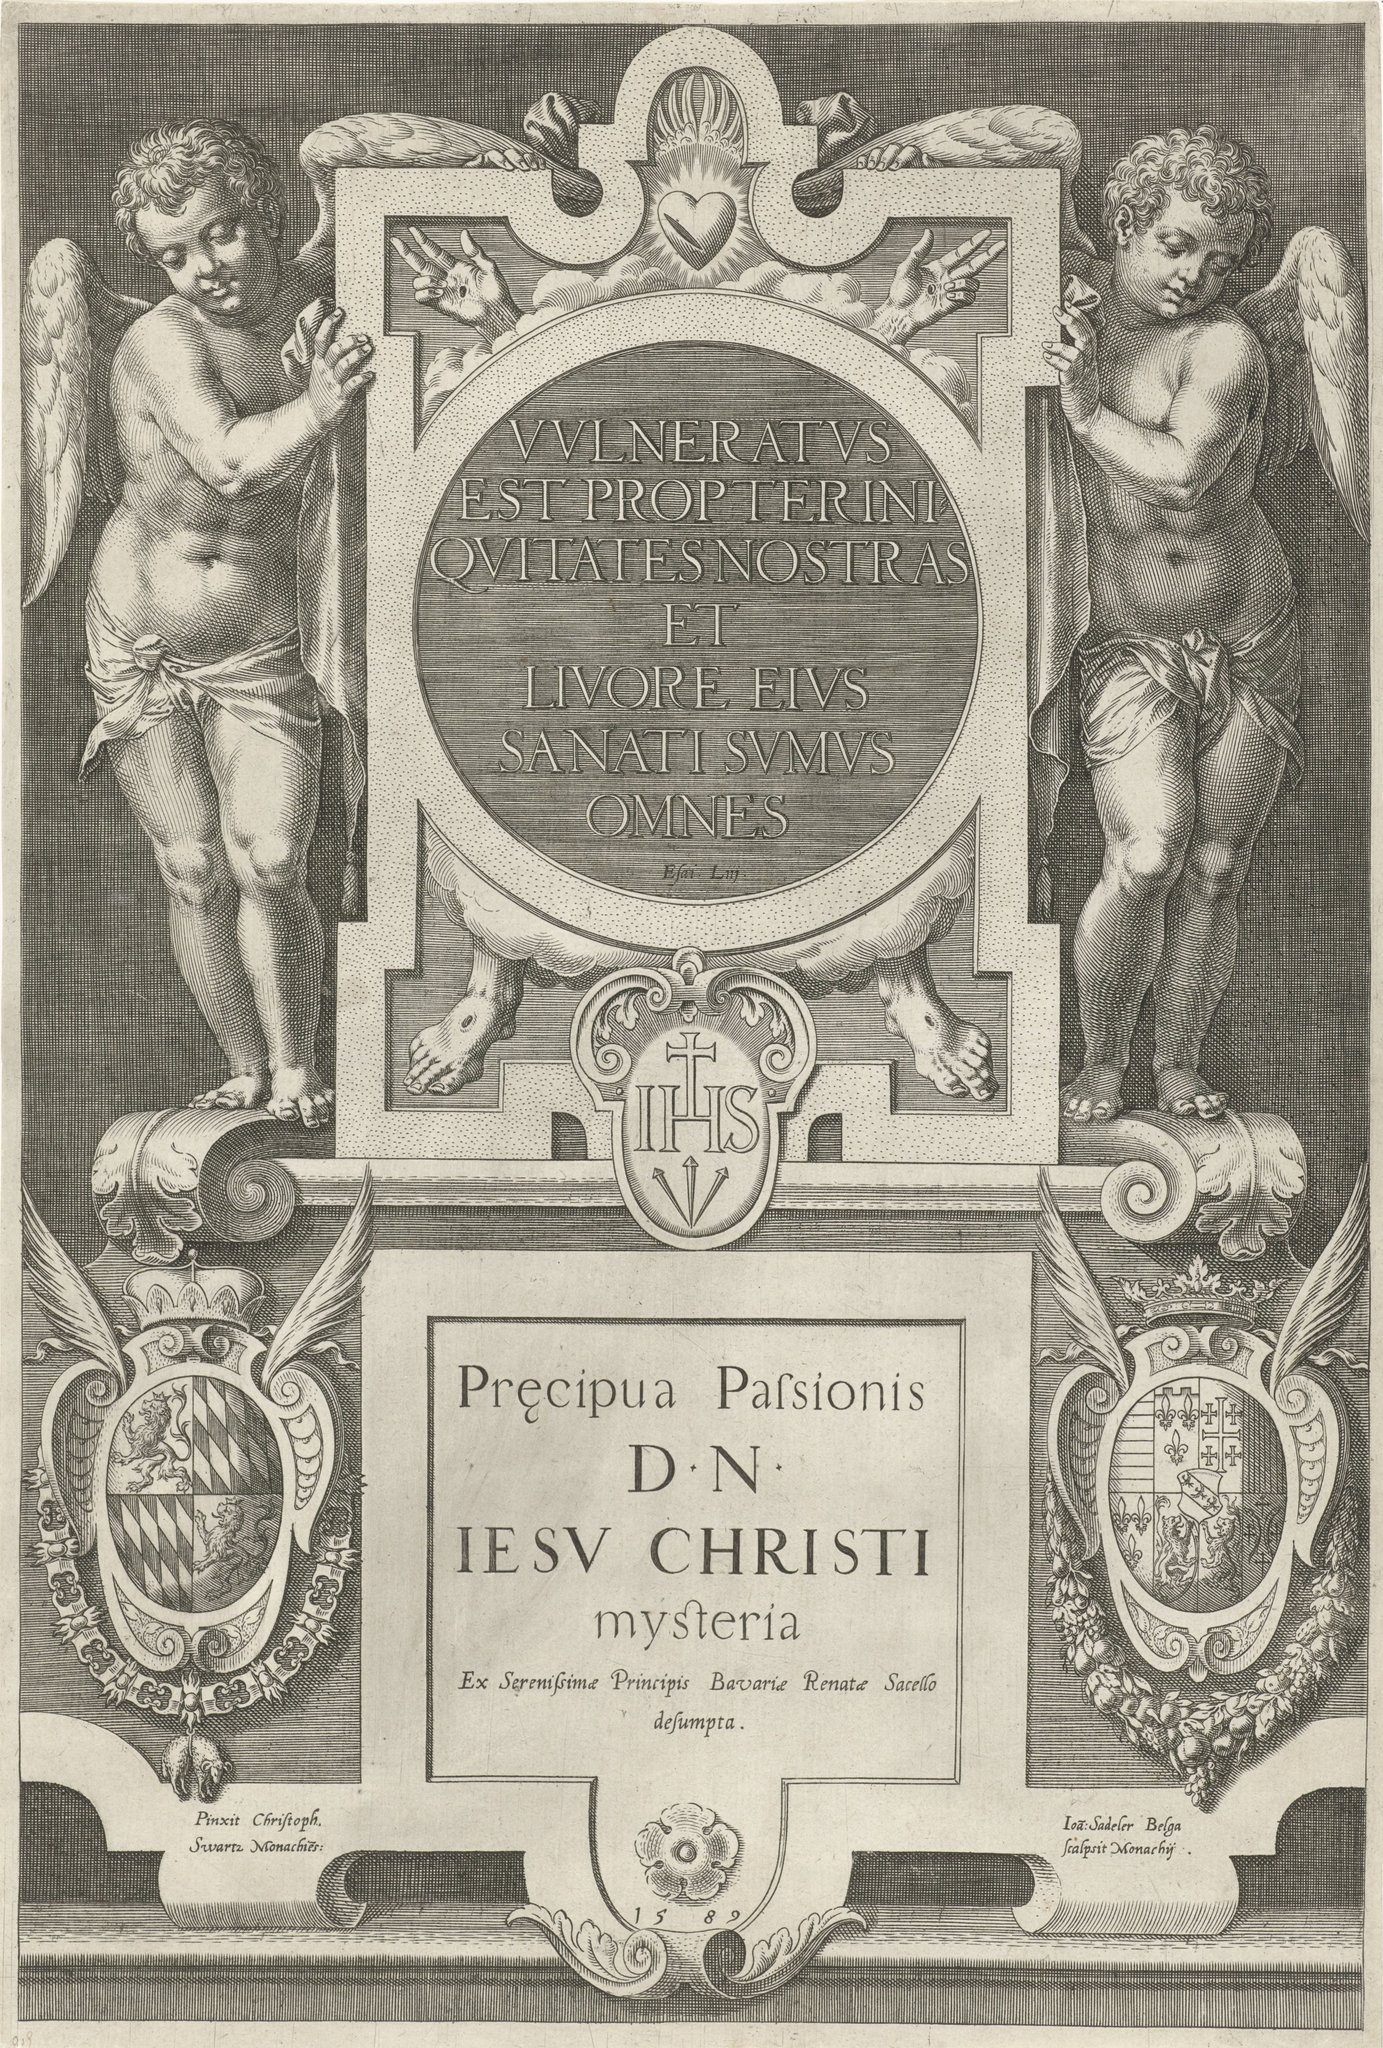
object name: titelprent, frontispice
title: Pręcipua Passionis D.N. Jesu Christi mysteria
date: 1589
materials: paper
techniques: engraving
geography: munich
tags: the five wounded limbs of christ: heart (side-wound), hands, and feet (+ angel(s)), armorial bearing, heraldry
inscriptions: collector's mark: Lugt 240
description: Twee engelen houden een kader vast. In het kader een Latijnse tekst en de vijf wonden van Christus. De engelen staan op een sokkel waarop de titel van de prentserie staat met aan weerszijden een wapenschild.